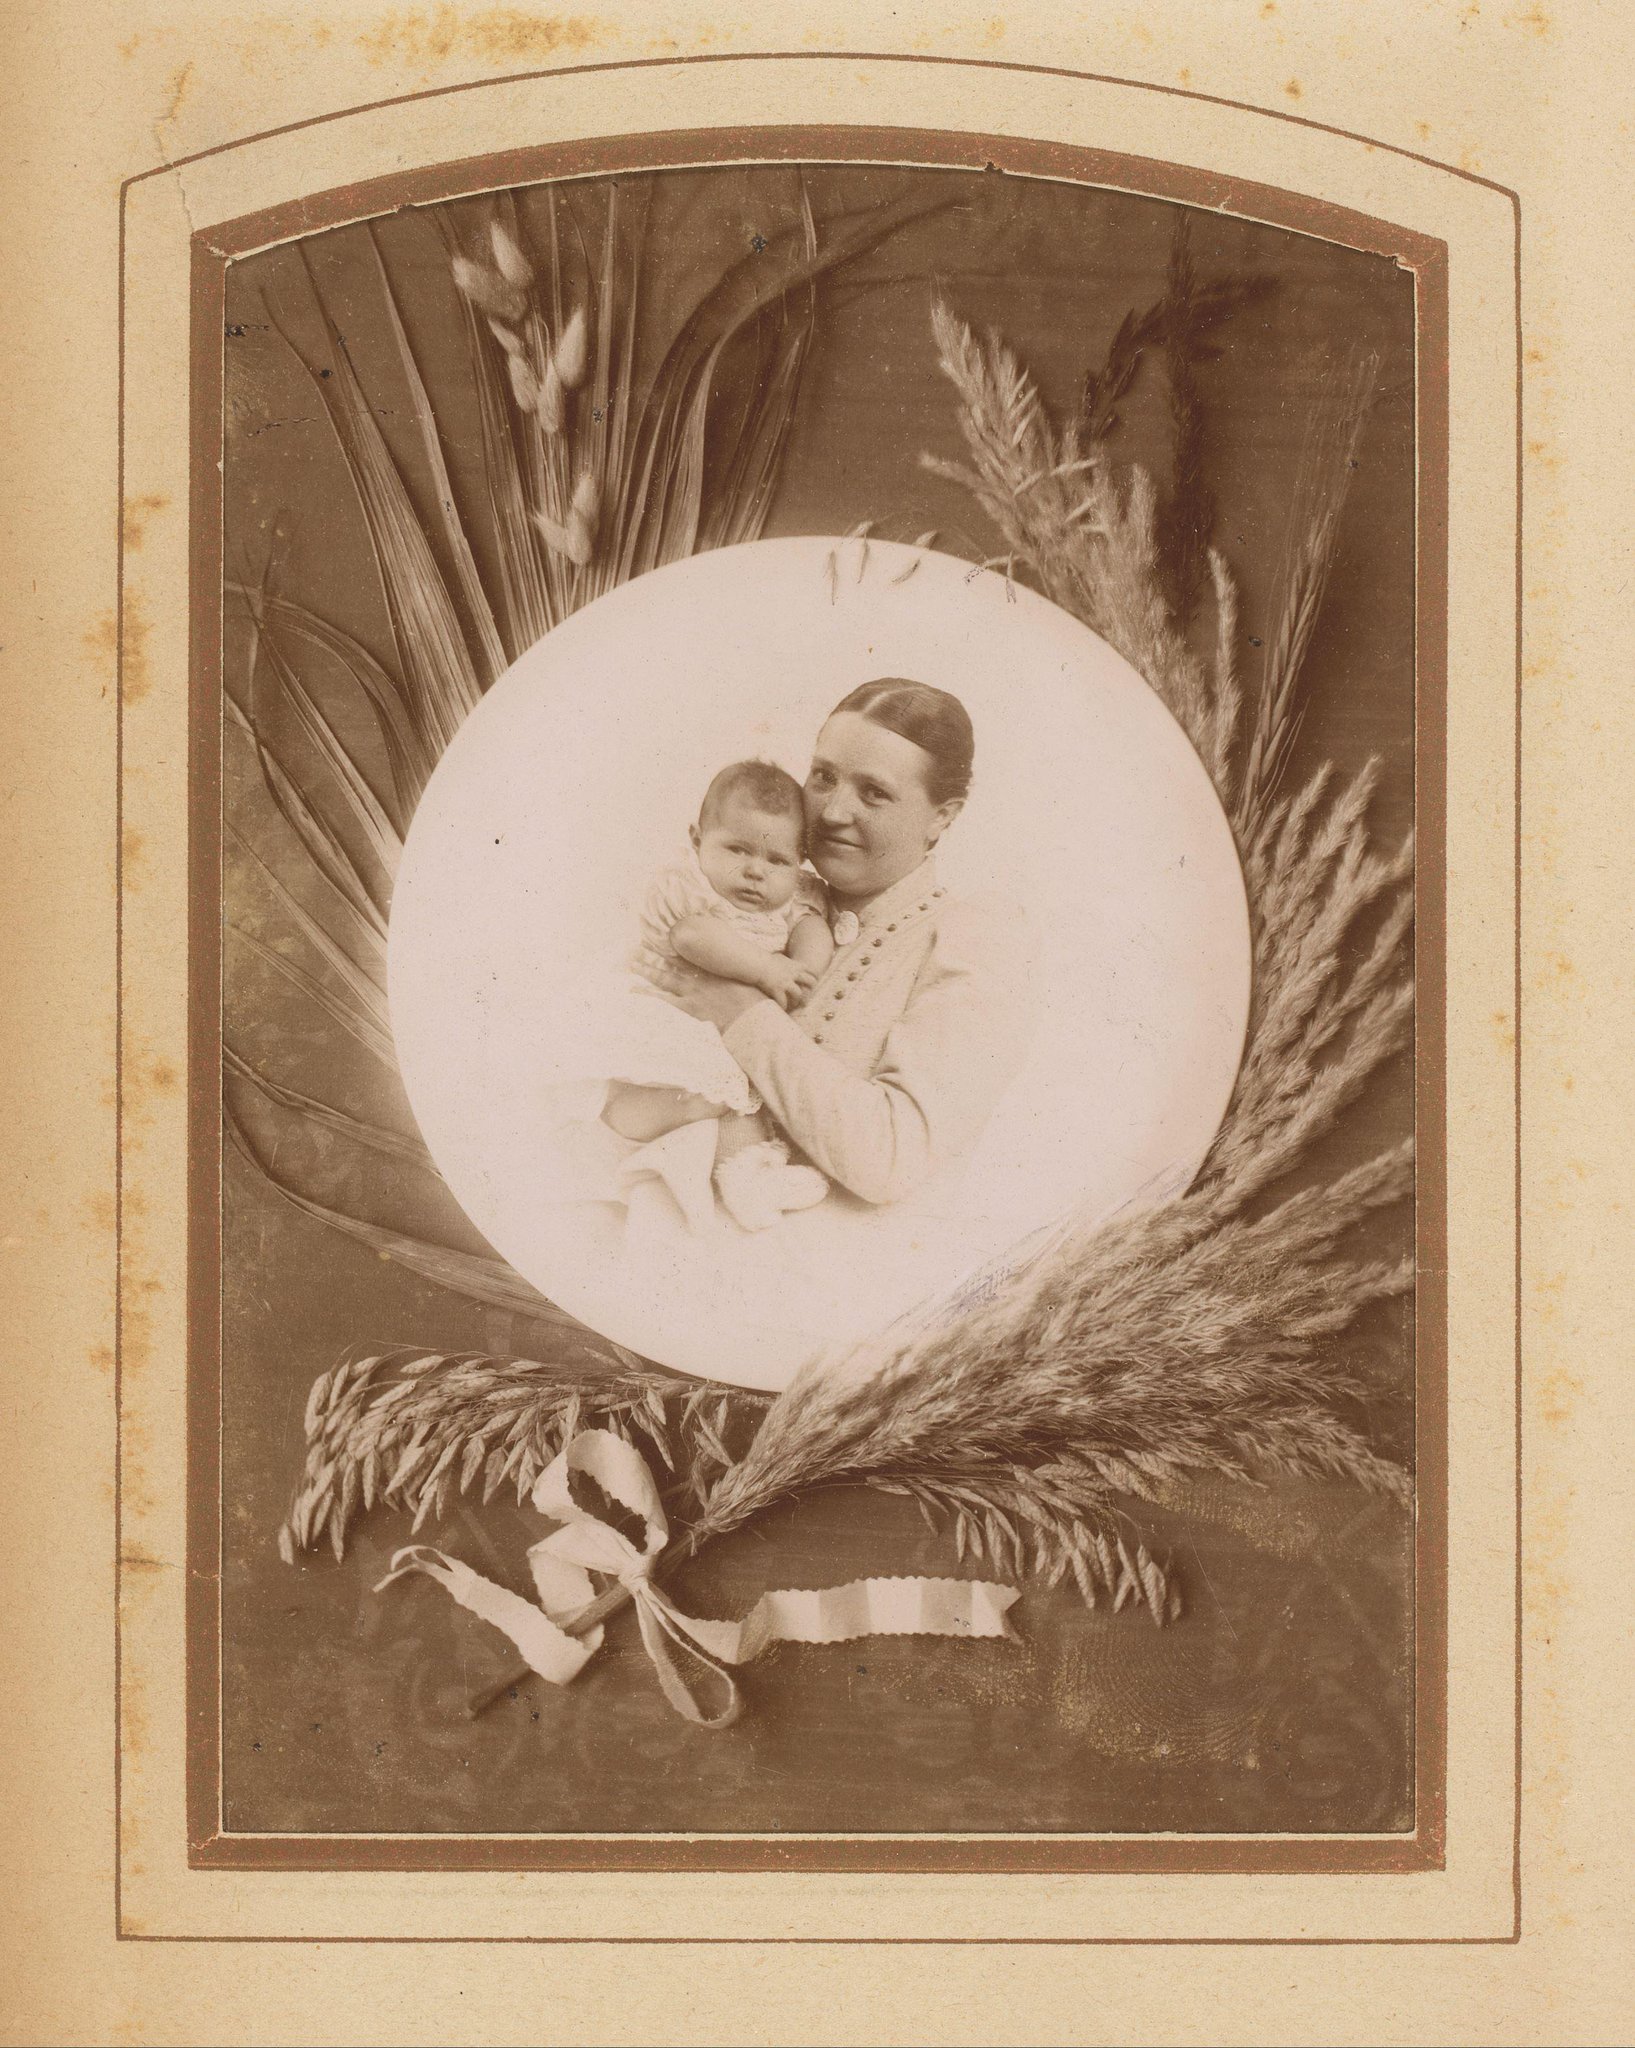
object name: cabinet photograph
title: Portret van een moeder met kind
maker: hendrik jonker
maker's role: fotograaf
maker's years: 1846-1932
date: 1892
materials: cardboard, photographic support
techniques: collodion silver print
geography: leiden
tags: mother and child(ren), woman and child(ren) (family group)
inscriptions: annotation: ‘[...]/ 10 Aug 1892’, inscription: ‘H. Jonker/ Leiden/ Apothekersdijk No7’